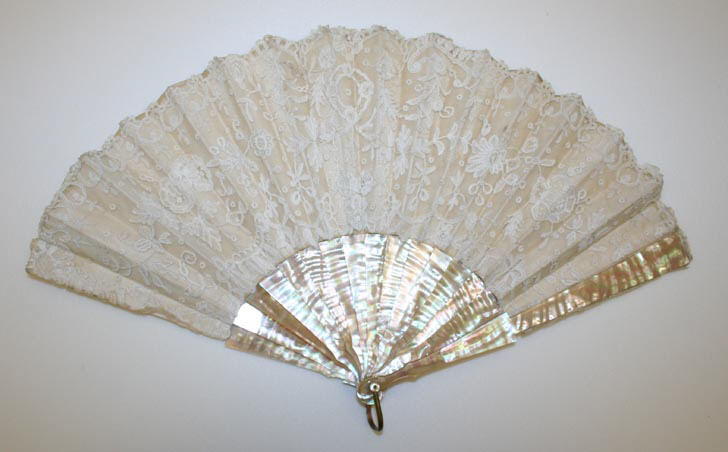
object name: fan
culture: french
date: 1850-1899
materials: mother of pearl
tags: flowers